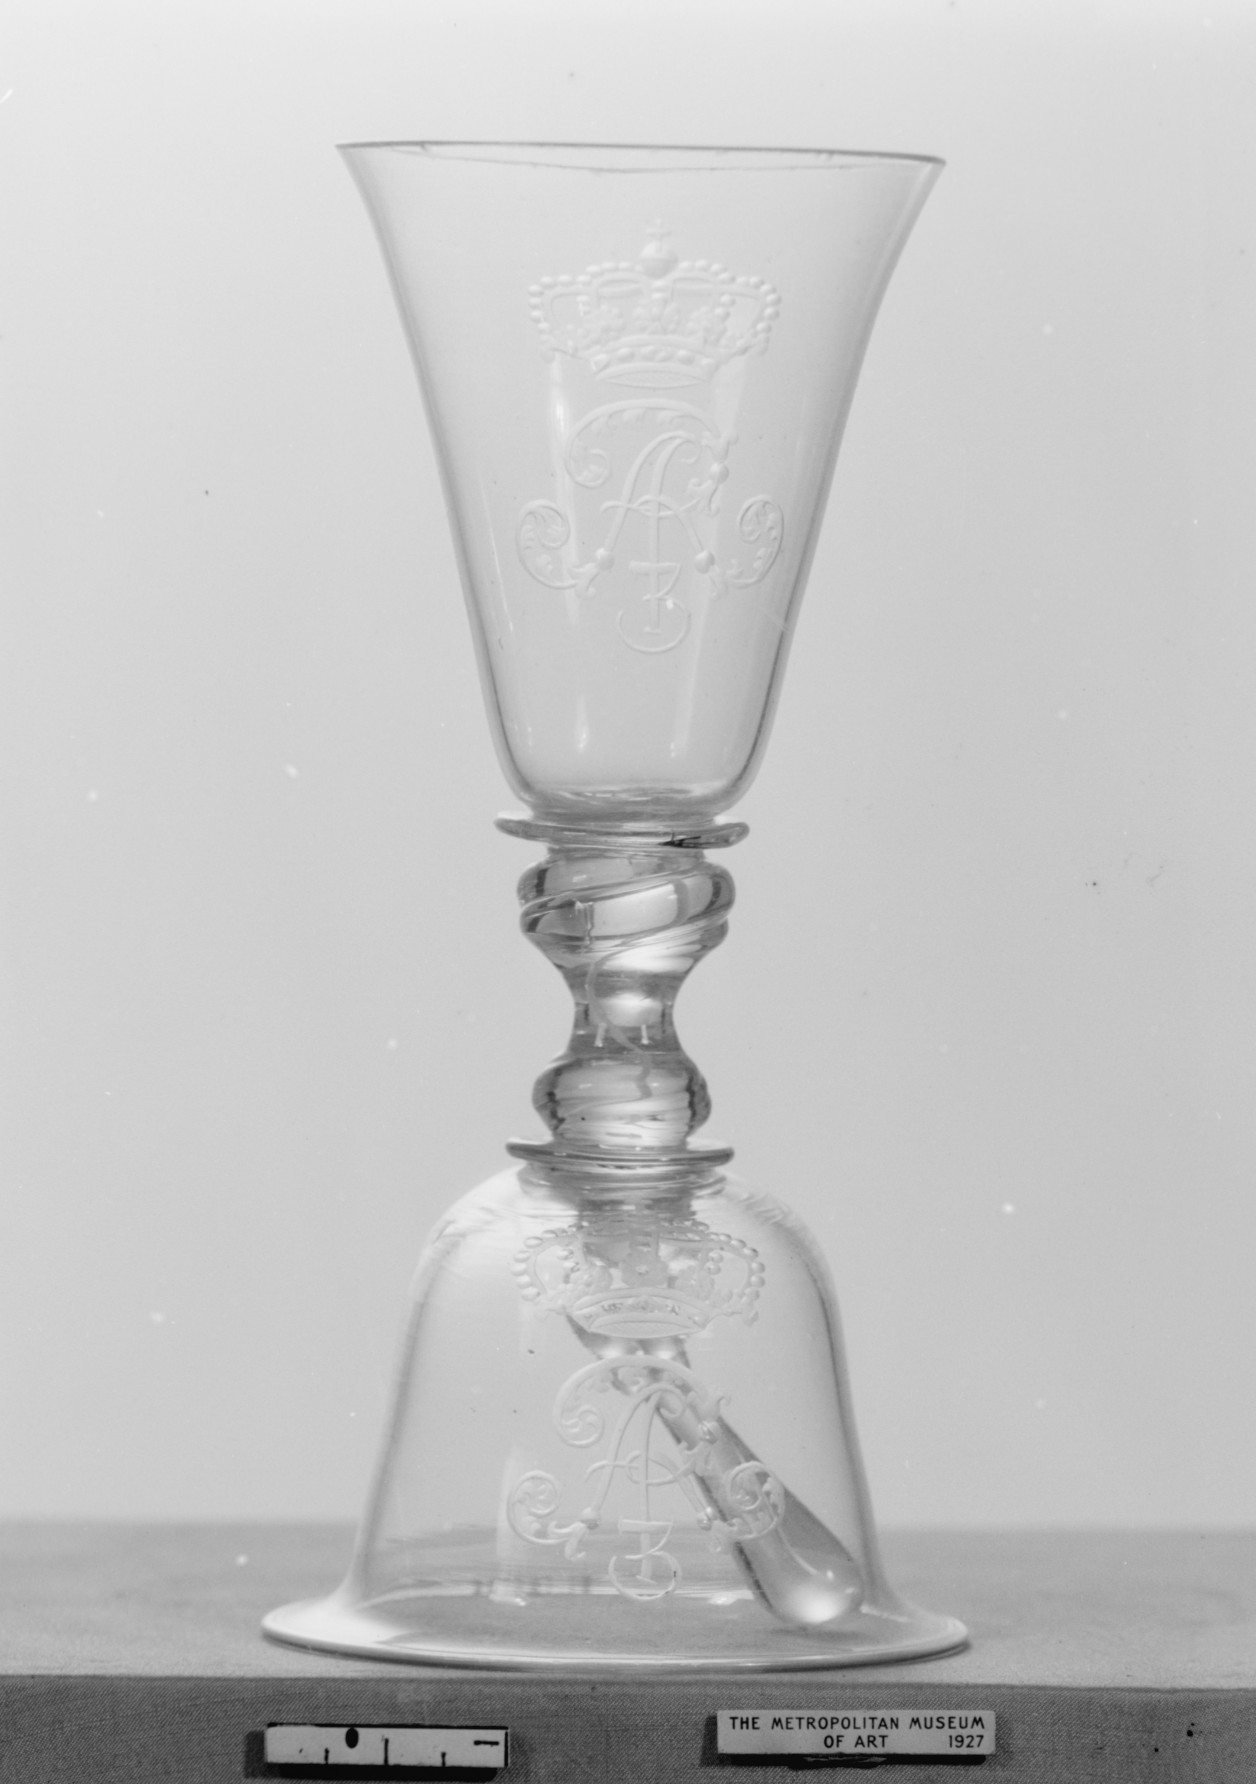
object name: goblet with bell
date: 1750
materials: glass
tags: musical instruments,insignia